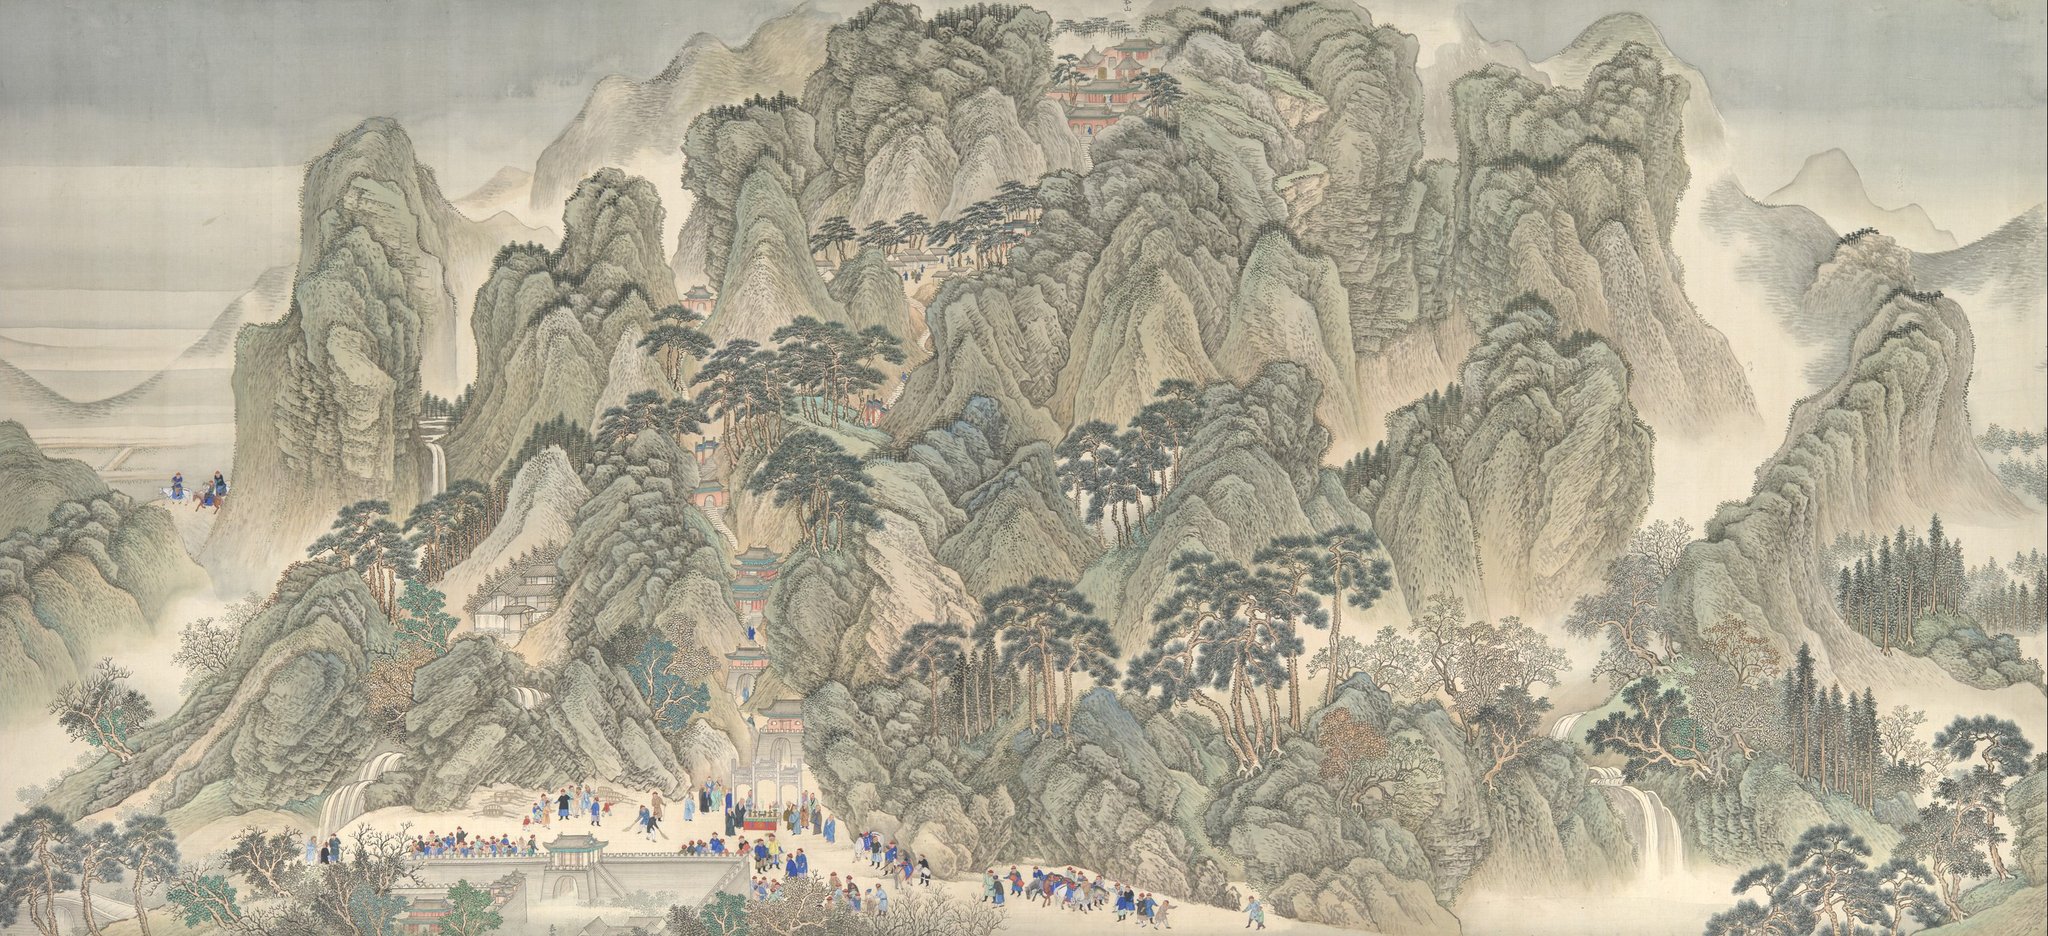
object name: handscroll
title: The Kangxi Emperor's Southern Inspection Tour, Scroll Three: Ji'nan to Mount Tai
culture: chinese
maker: wang hui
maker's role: artist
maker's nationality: chinese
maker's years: 1632-1717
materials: ink, silk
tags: mountains,landscapes